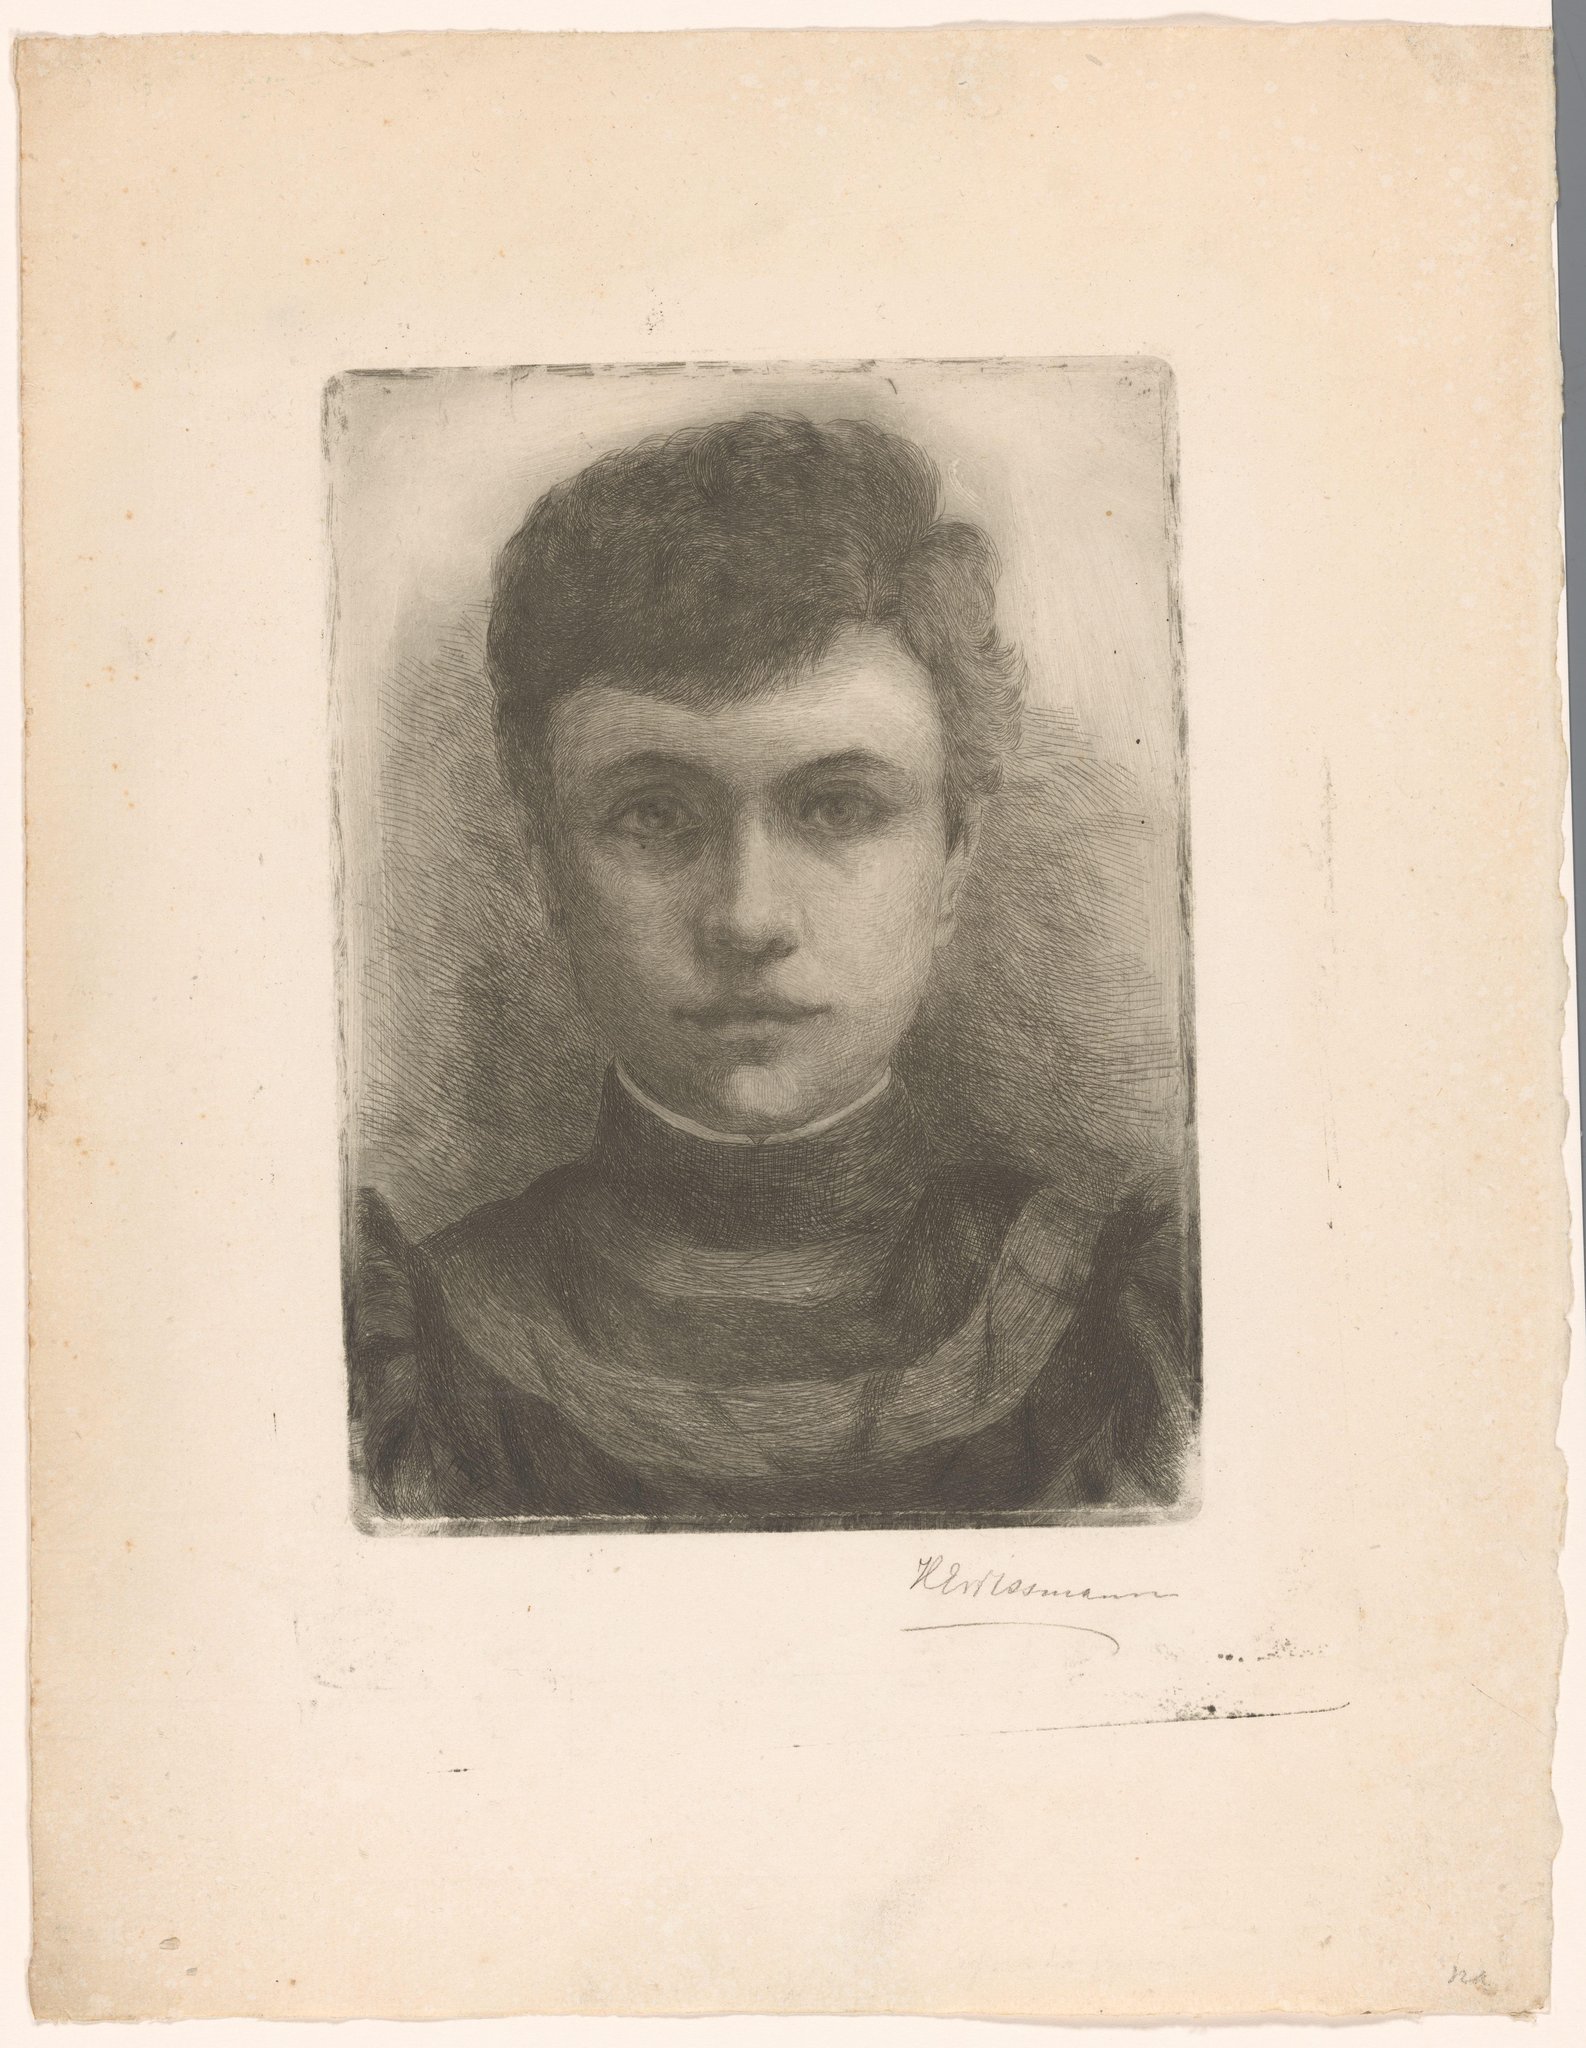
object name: print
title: Portret van een jonge onbekende vrouw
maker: h.e. wissmann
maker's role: print maker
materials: paper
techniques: drypoint, etching, intaglio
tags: historical persons not known by name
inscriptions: collector's mark: Lugt 2228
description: Mogelijk een portret van Agnita Gijswijt.